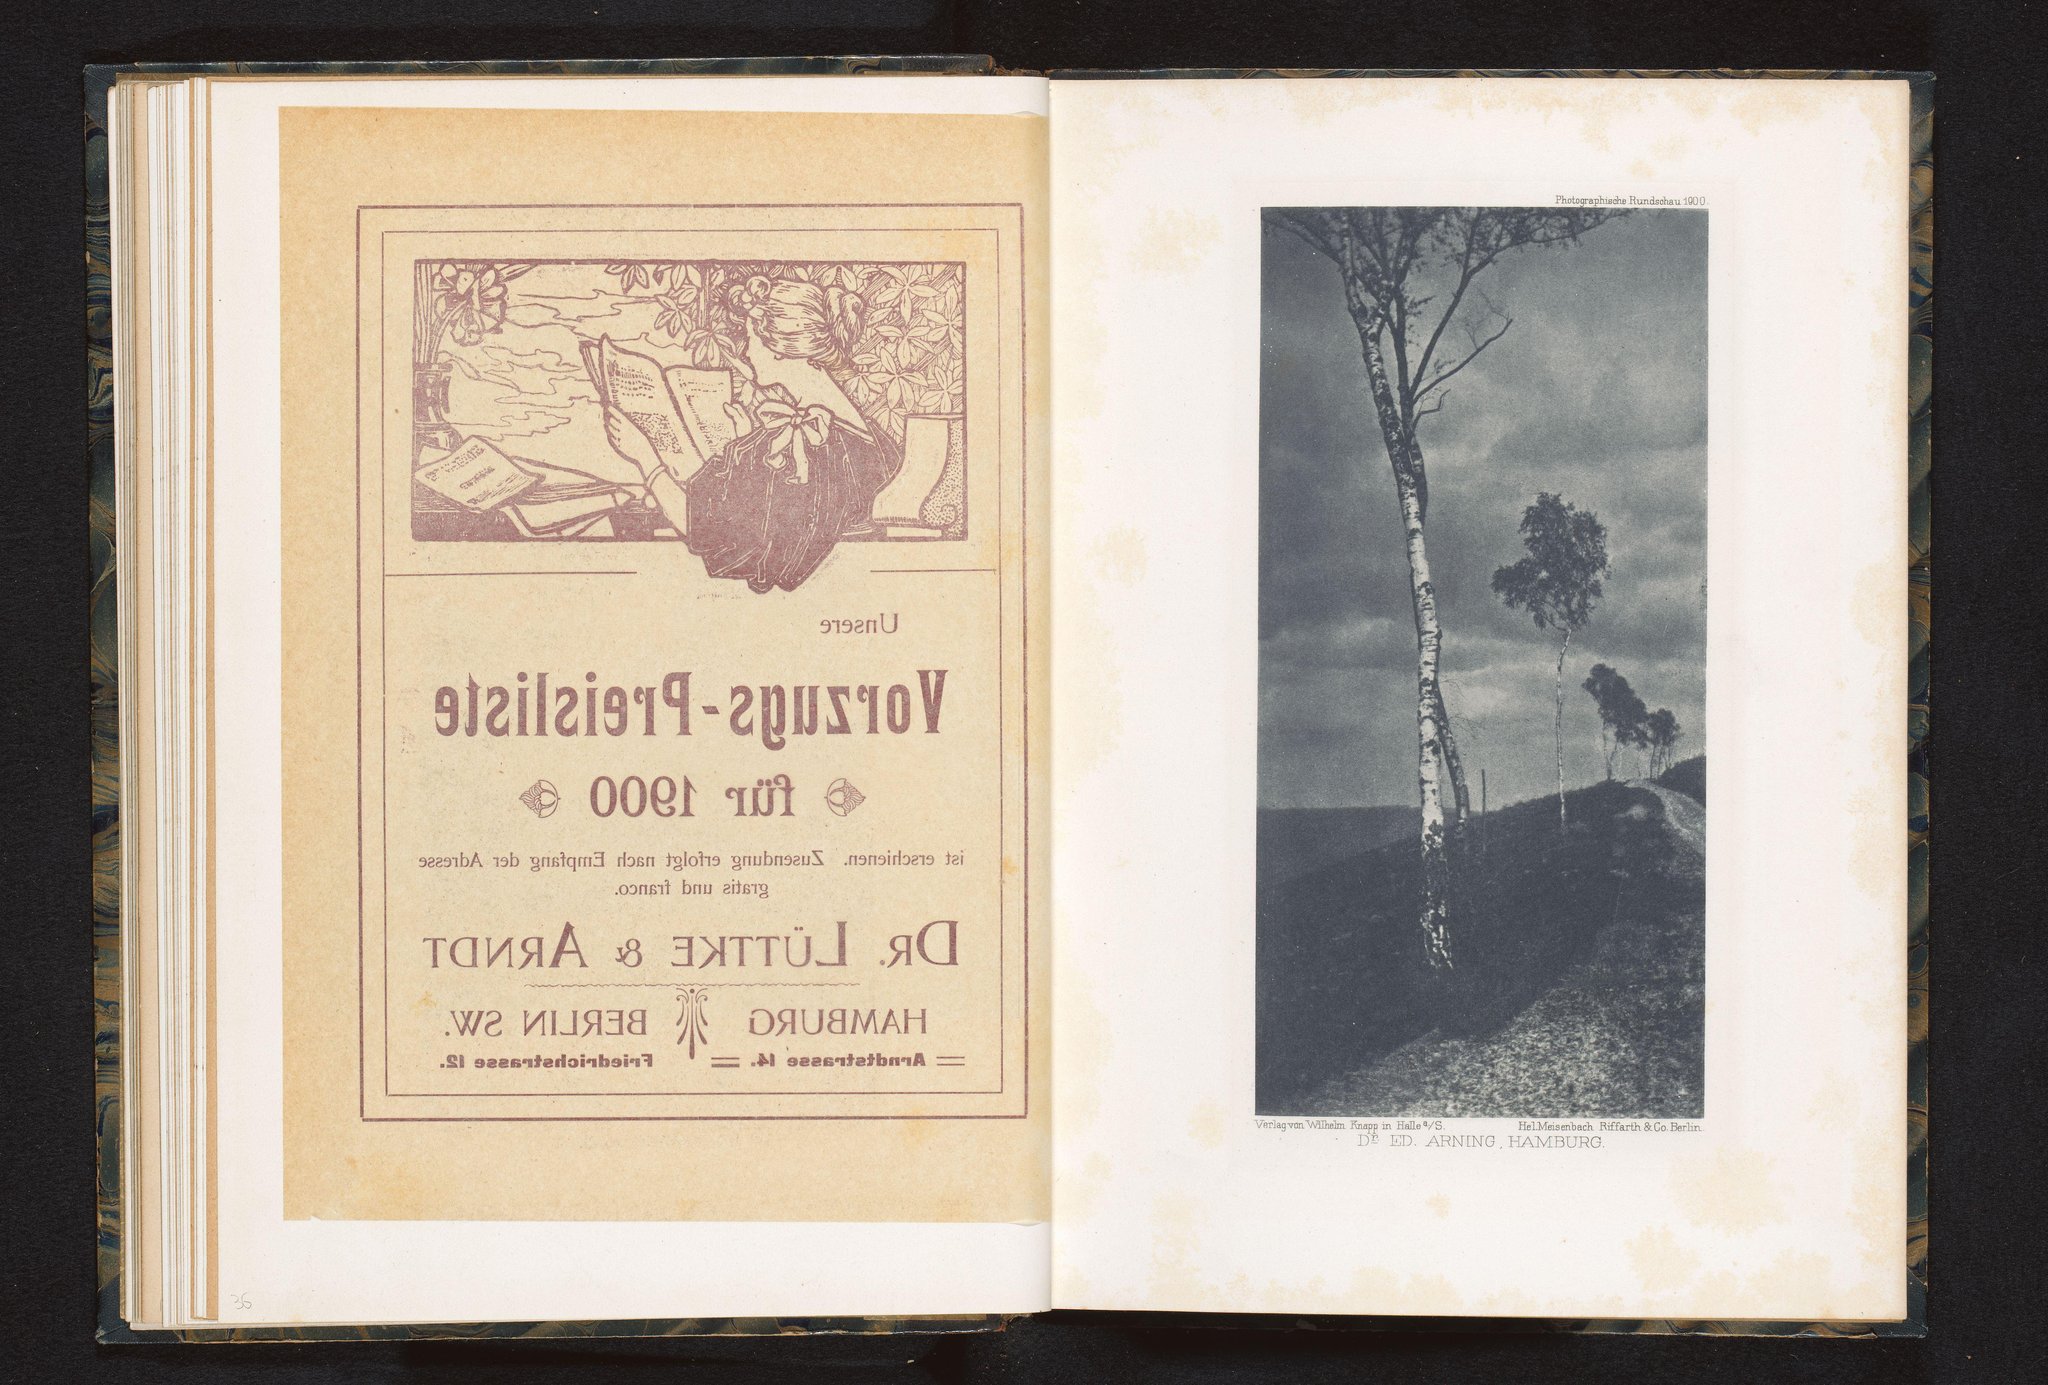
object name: page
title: Gezicht op een rij bomen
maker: eduard arning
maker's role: fotograaf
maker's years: 1855-1936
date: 1895-1900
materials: paper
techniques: photoaquatint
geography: halle an der saale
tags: trees